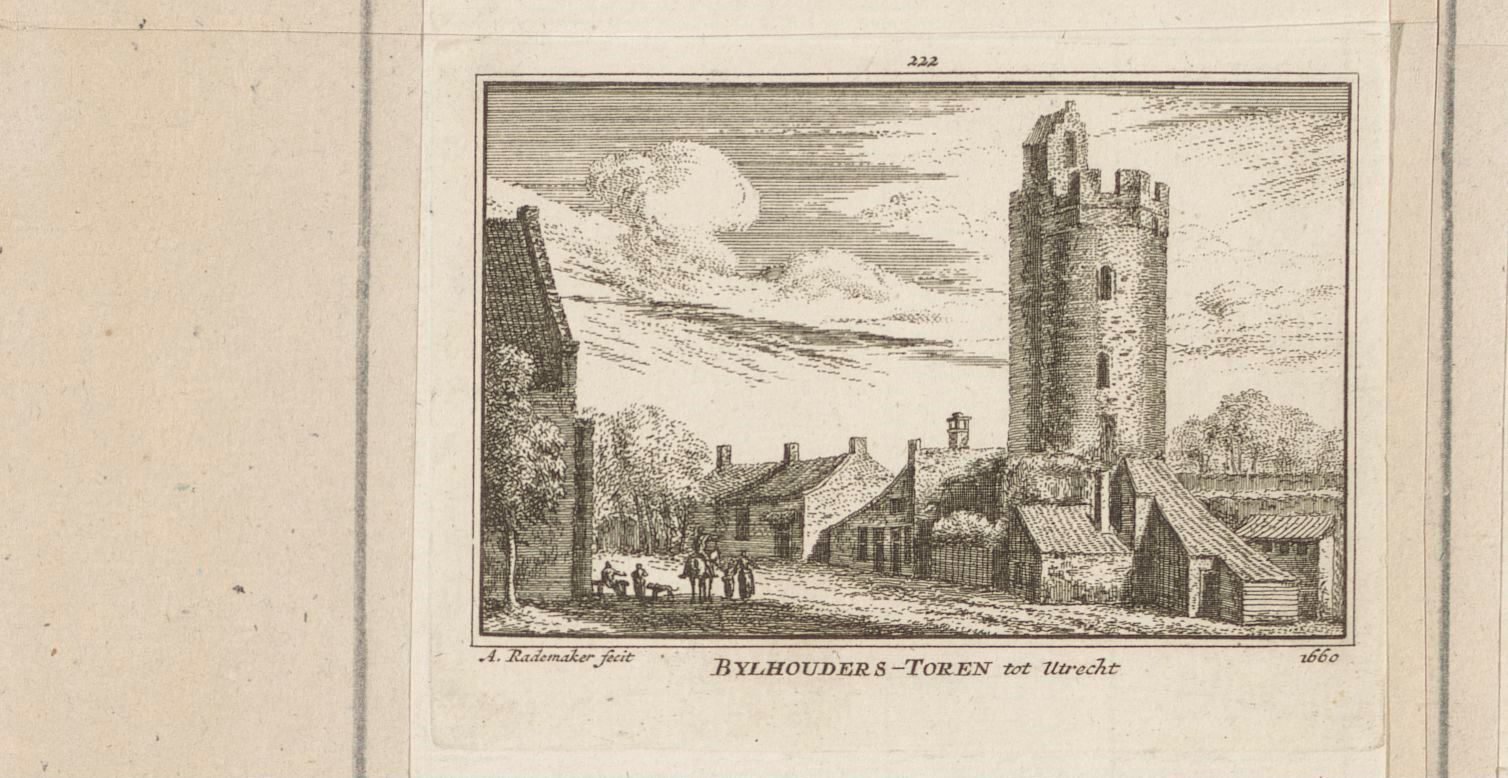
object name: print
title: Bylhouders-toren tot Utrecht 1660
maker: abraham rademaker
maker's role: draughtsman, print maker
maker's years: 1676-1735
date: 1725-1803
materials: paper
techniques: engraving, etching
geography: amsterdam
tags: bijlhouwerstoren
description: Prent ook gebruikt in: Rademaker, Abraham. Kabinet van Nederlandsche outheden en gezichten: vervat in 300 konstplaaten (…). 2 delen. Amsterdam: Willem Barents, 1725, dl. 2, ill. 222. Na 1725 is deze prent nog in verschillende heruitgaven verschenen, uitgegeven in 1727-1733, 1770-1771 en 1792-1803. Uit welke uitgave het huidige exemplaar precies komt is niet na te gaan.